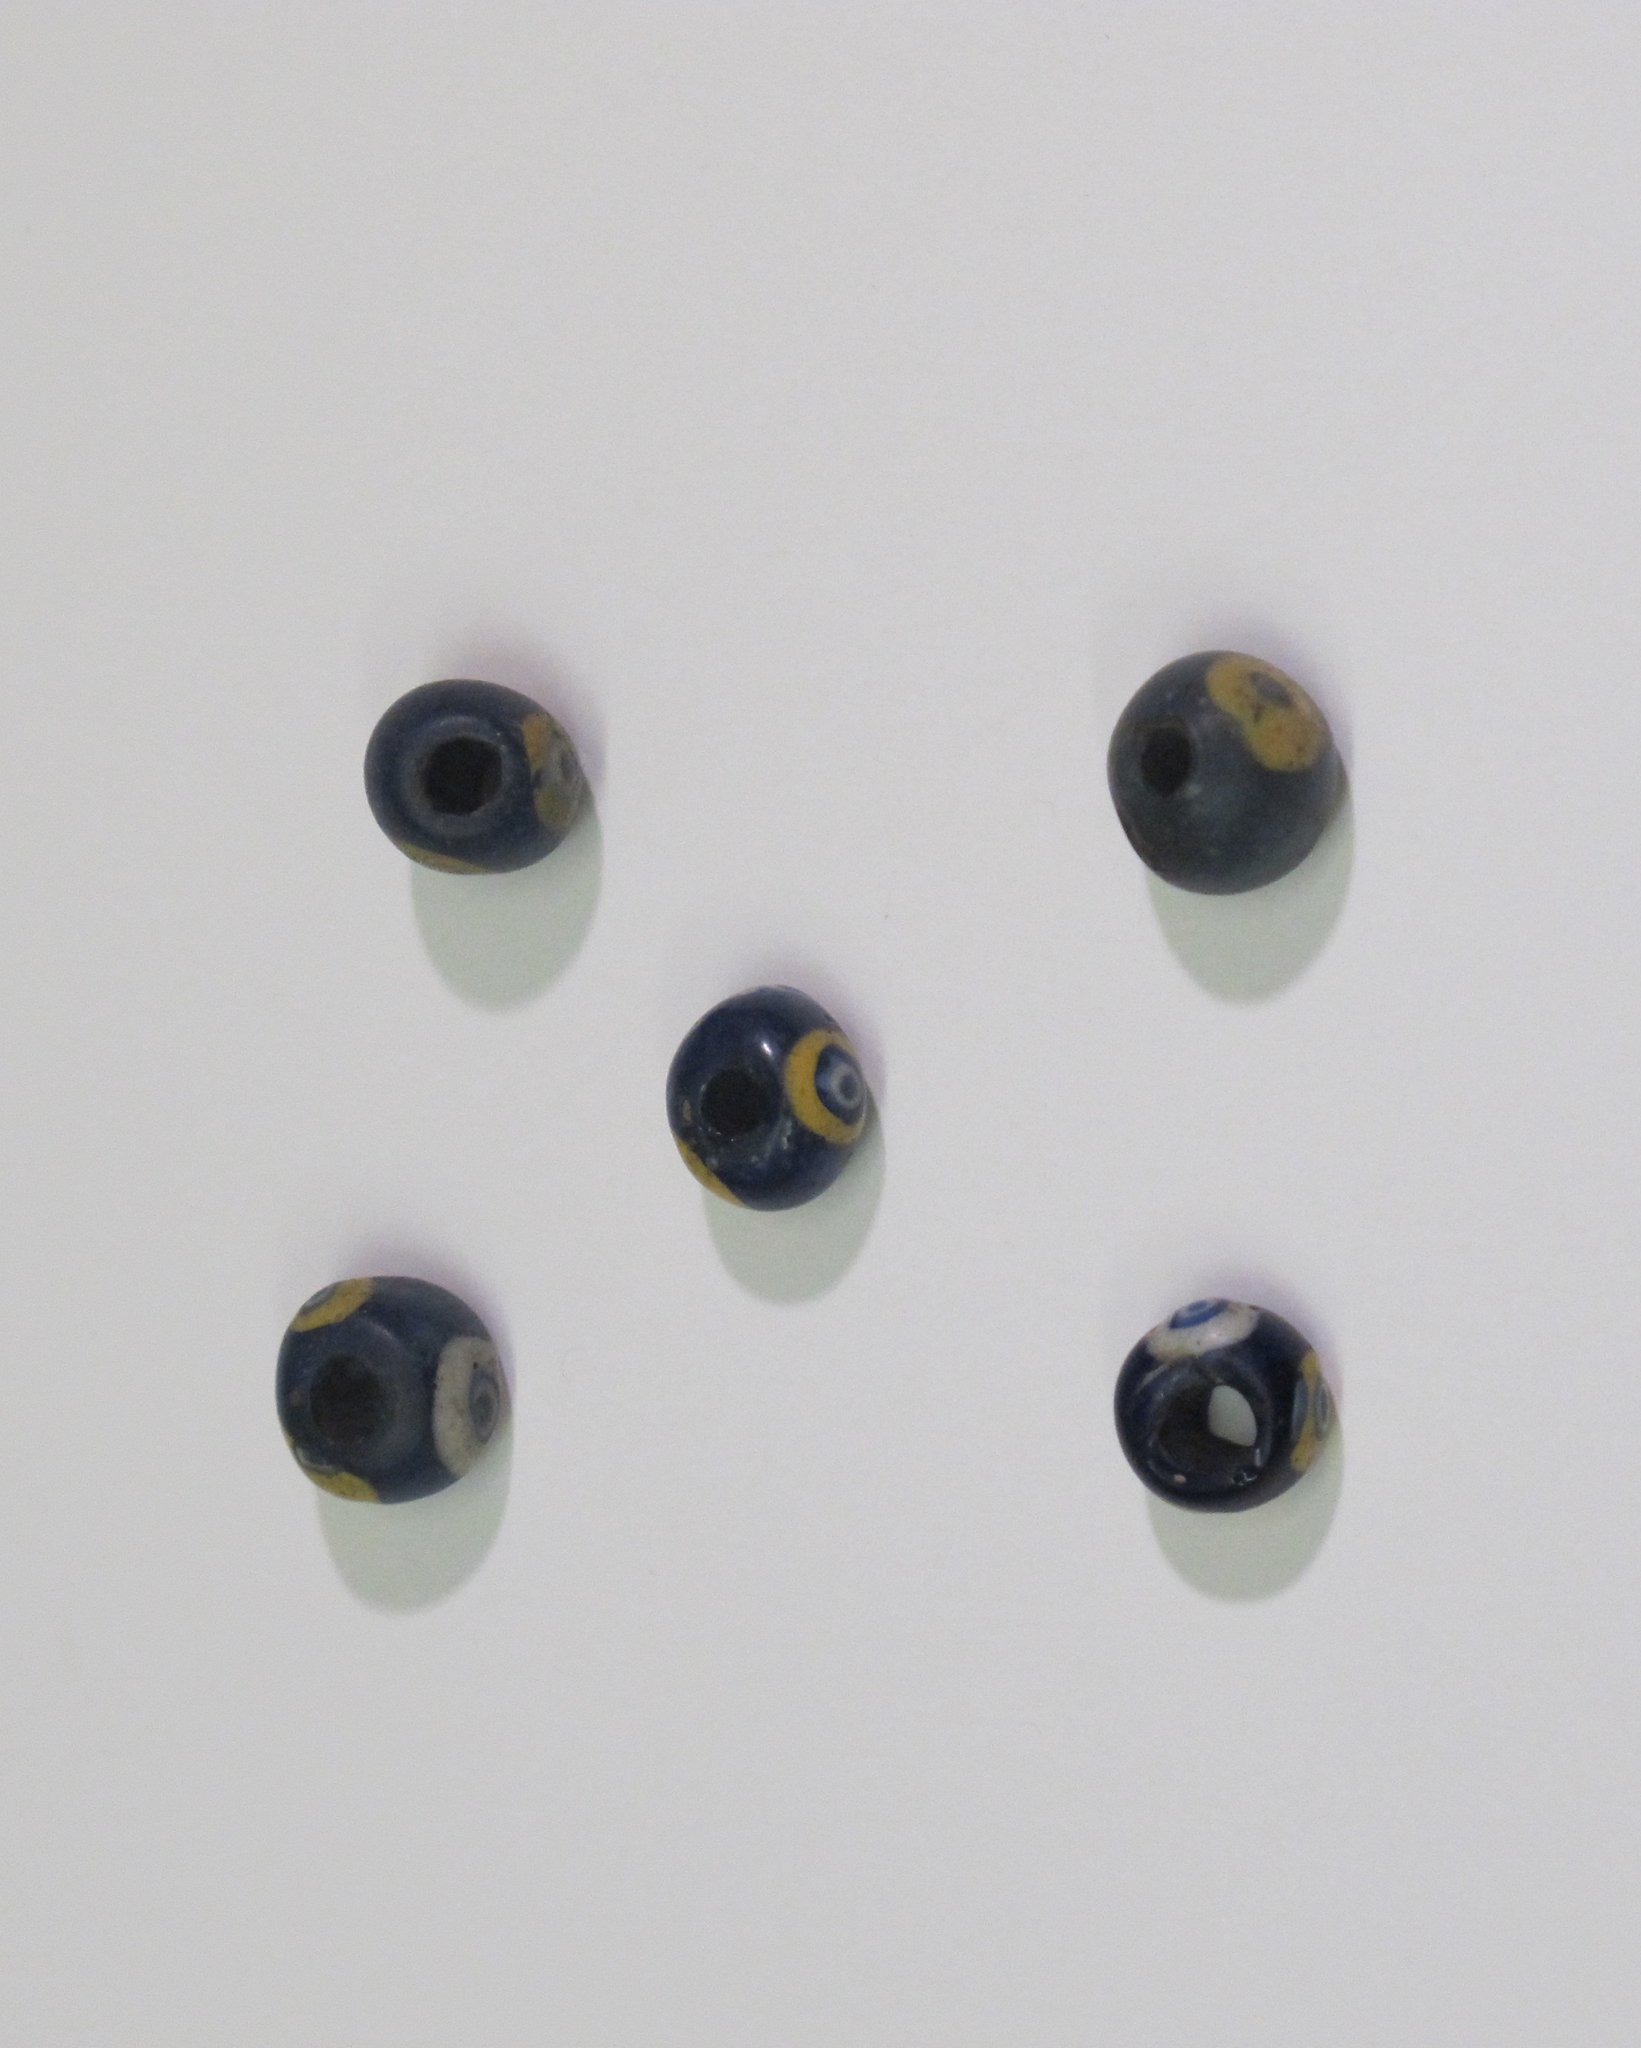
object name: bead, eye dish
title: Group of 5 composite eye beads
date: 1-366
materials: glass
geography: egypt